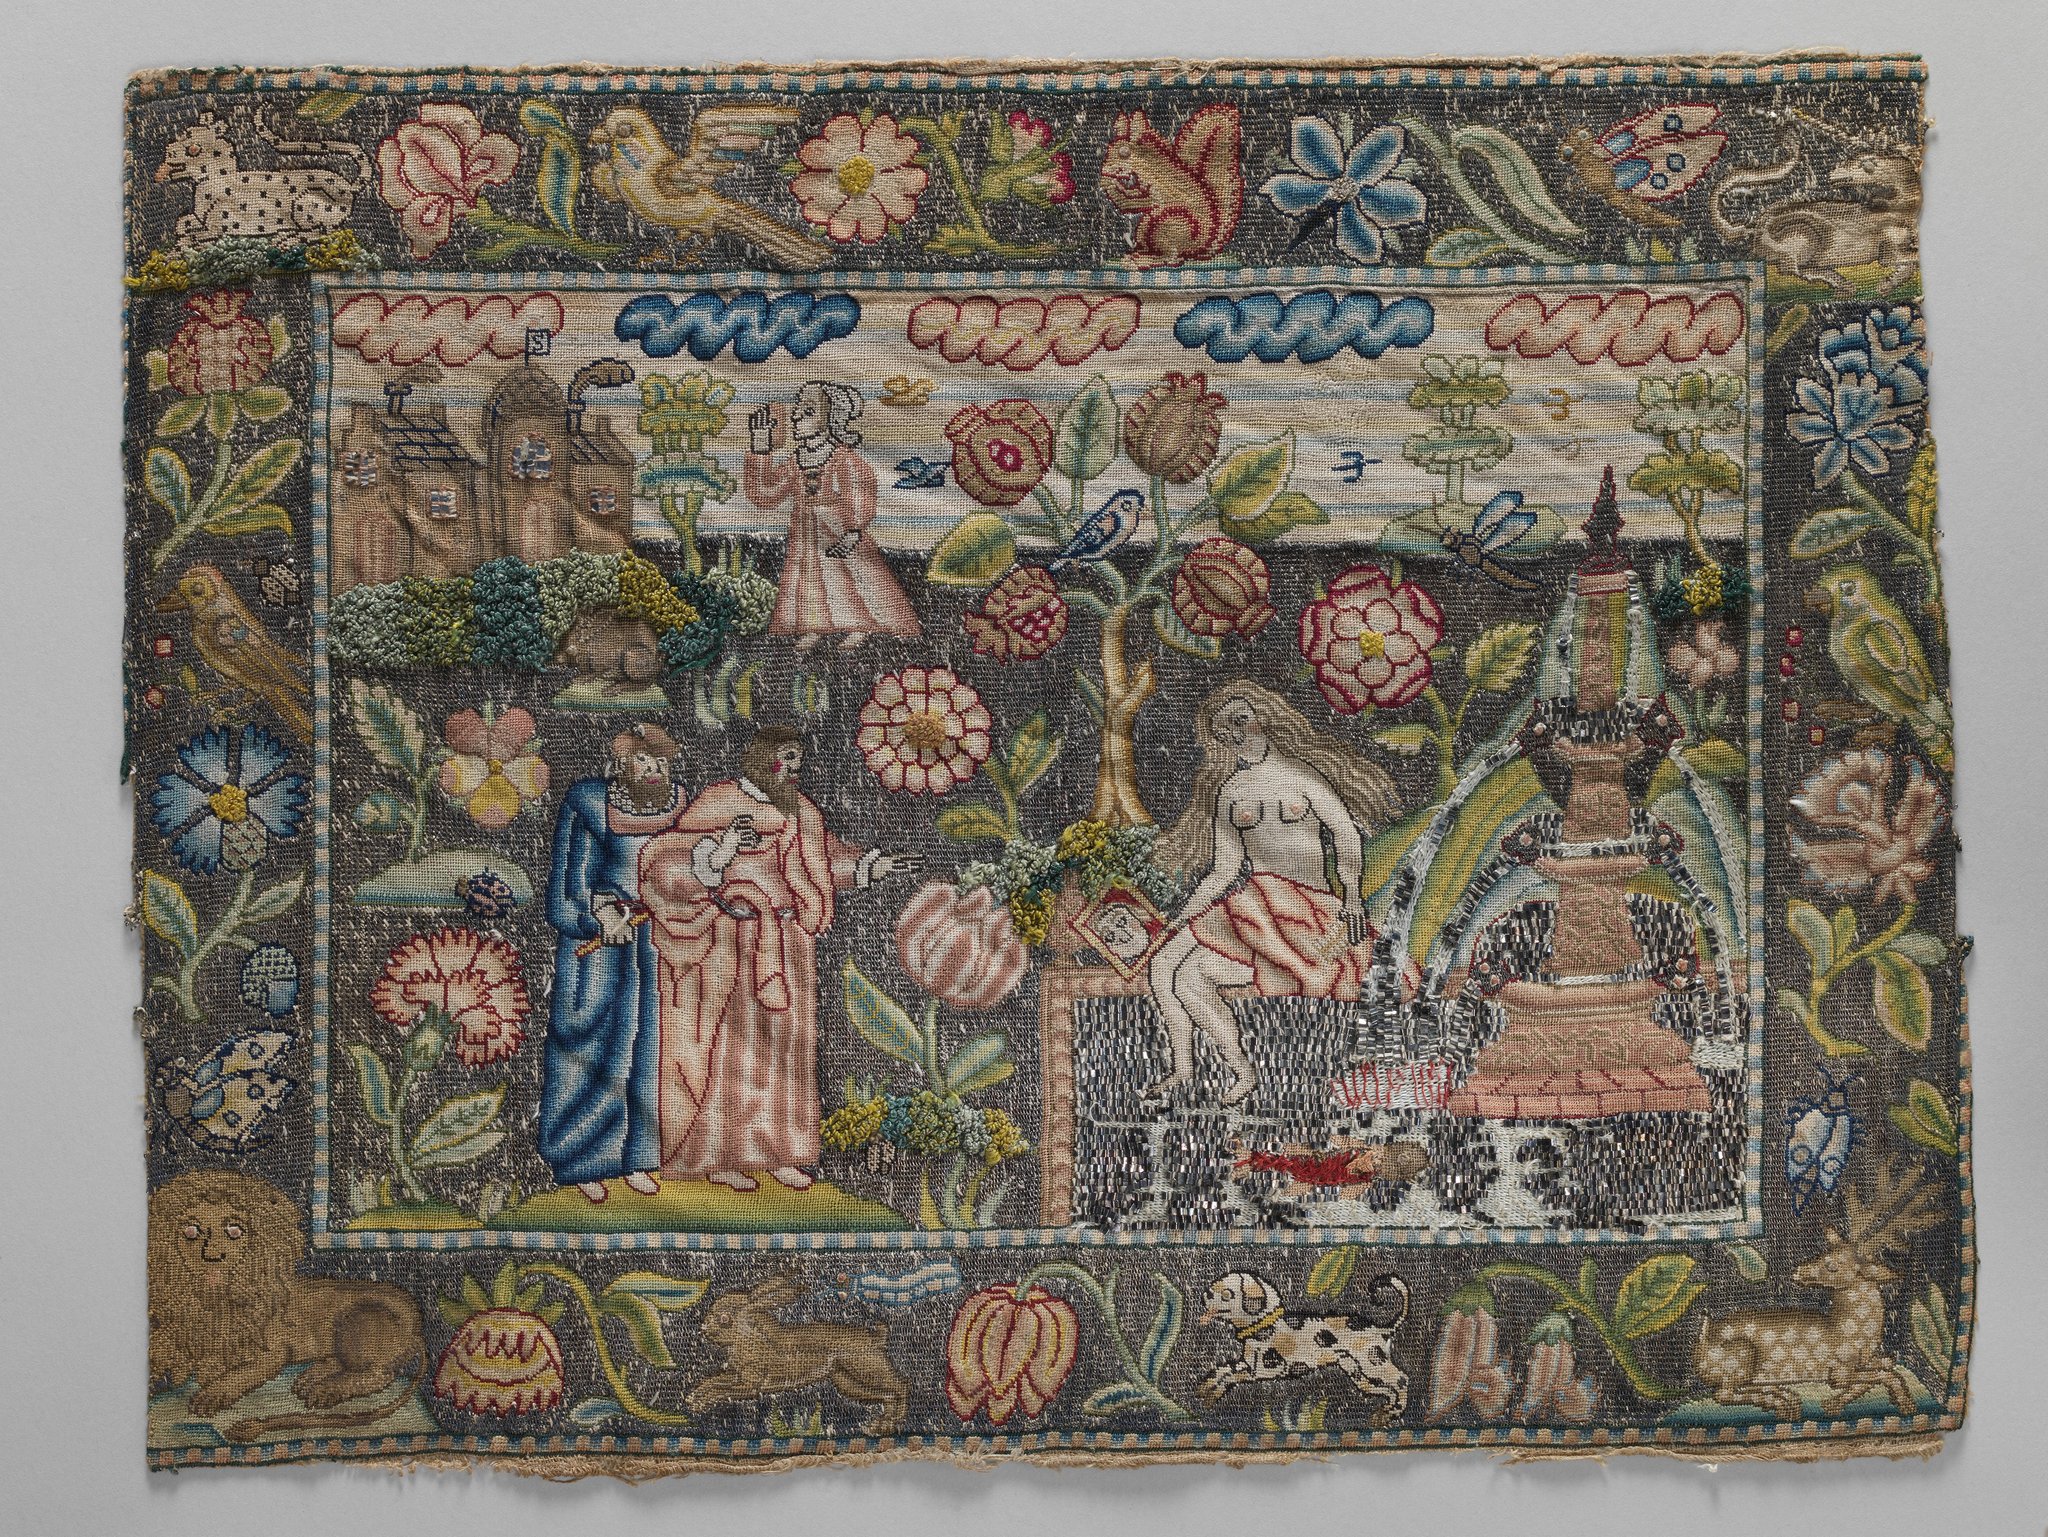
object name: embroidered picture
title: Susanna and the Elders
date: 1634-1666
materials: canvas, metal thread, silk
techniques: embroidery, stitching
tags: birds,female nudes,deer,dogs,lions,rabbits,flowers